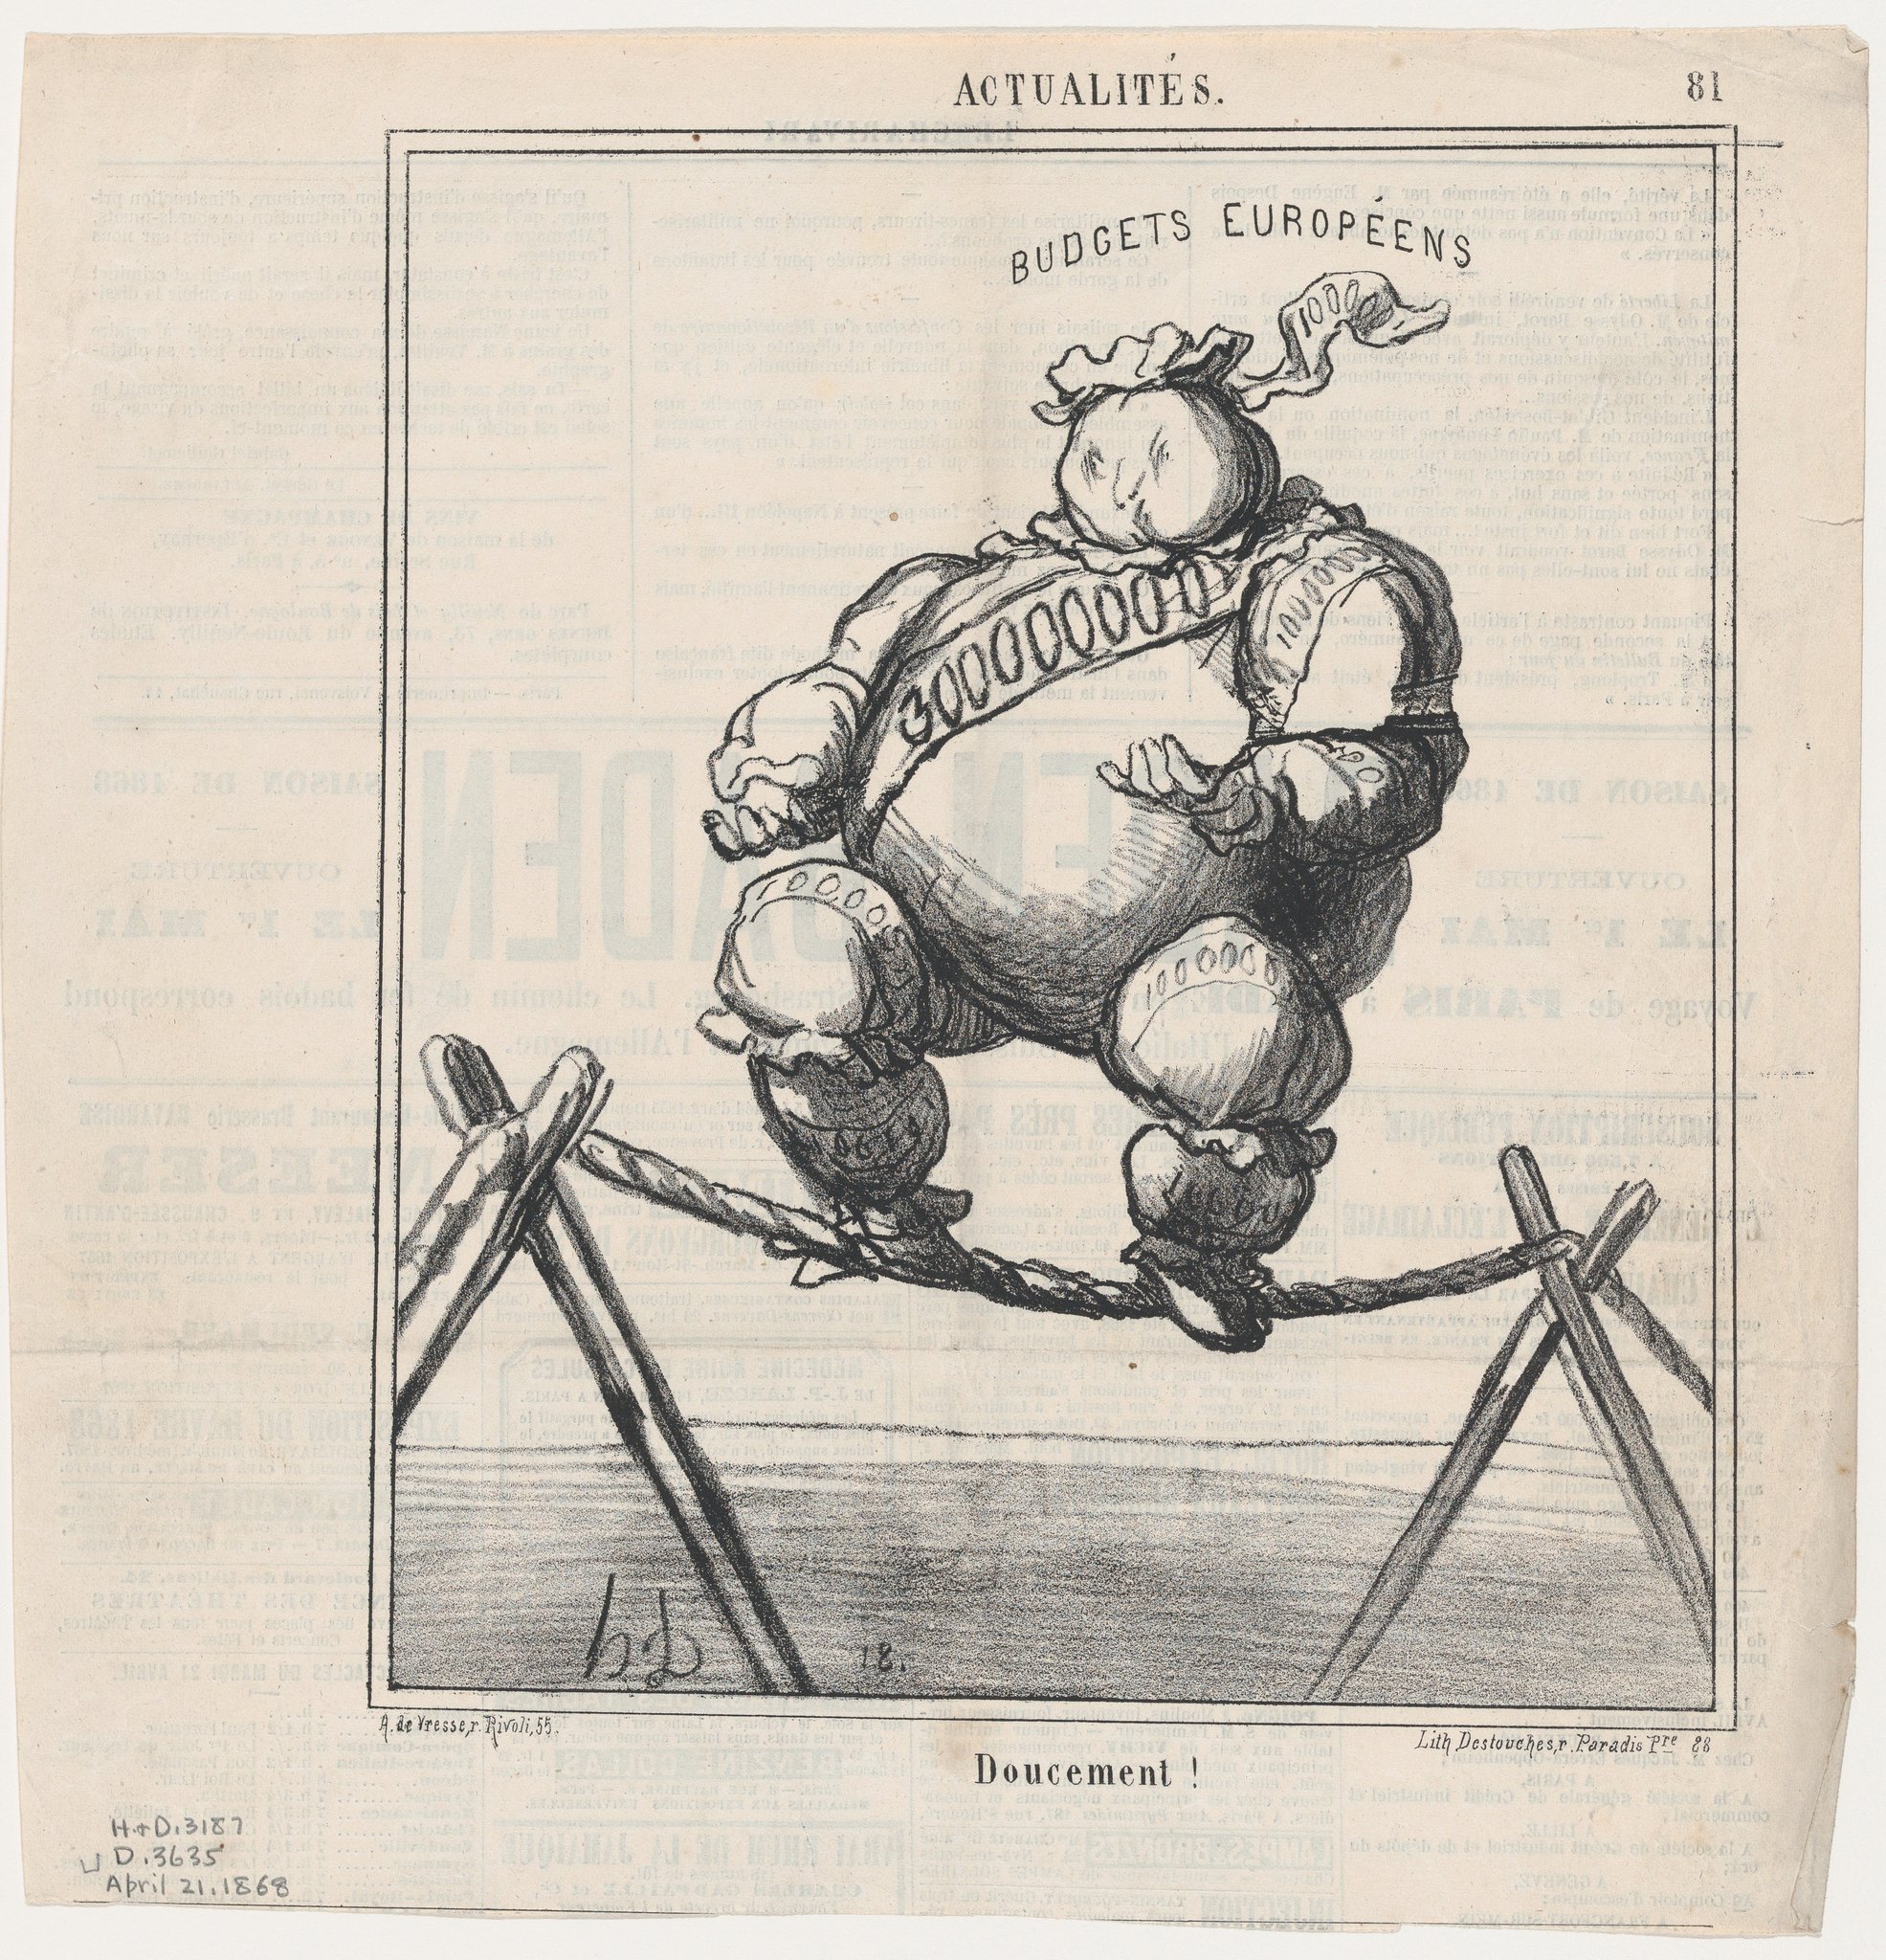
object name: print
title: Gently!, from 'News of the day,' published in Le Charivari, April 21, 1868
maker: honoré daumier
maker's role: artist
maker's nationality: french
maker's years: 1808-1879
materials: paper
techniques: lithograph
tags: satire,acrobats